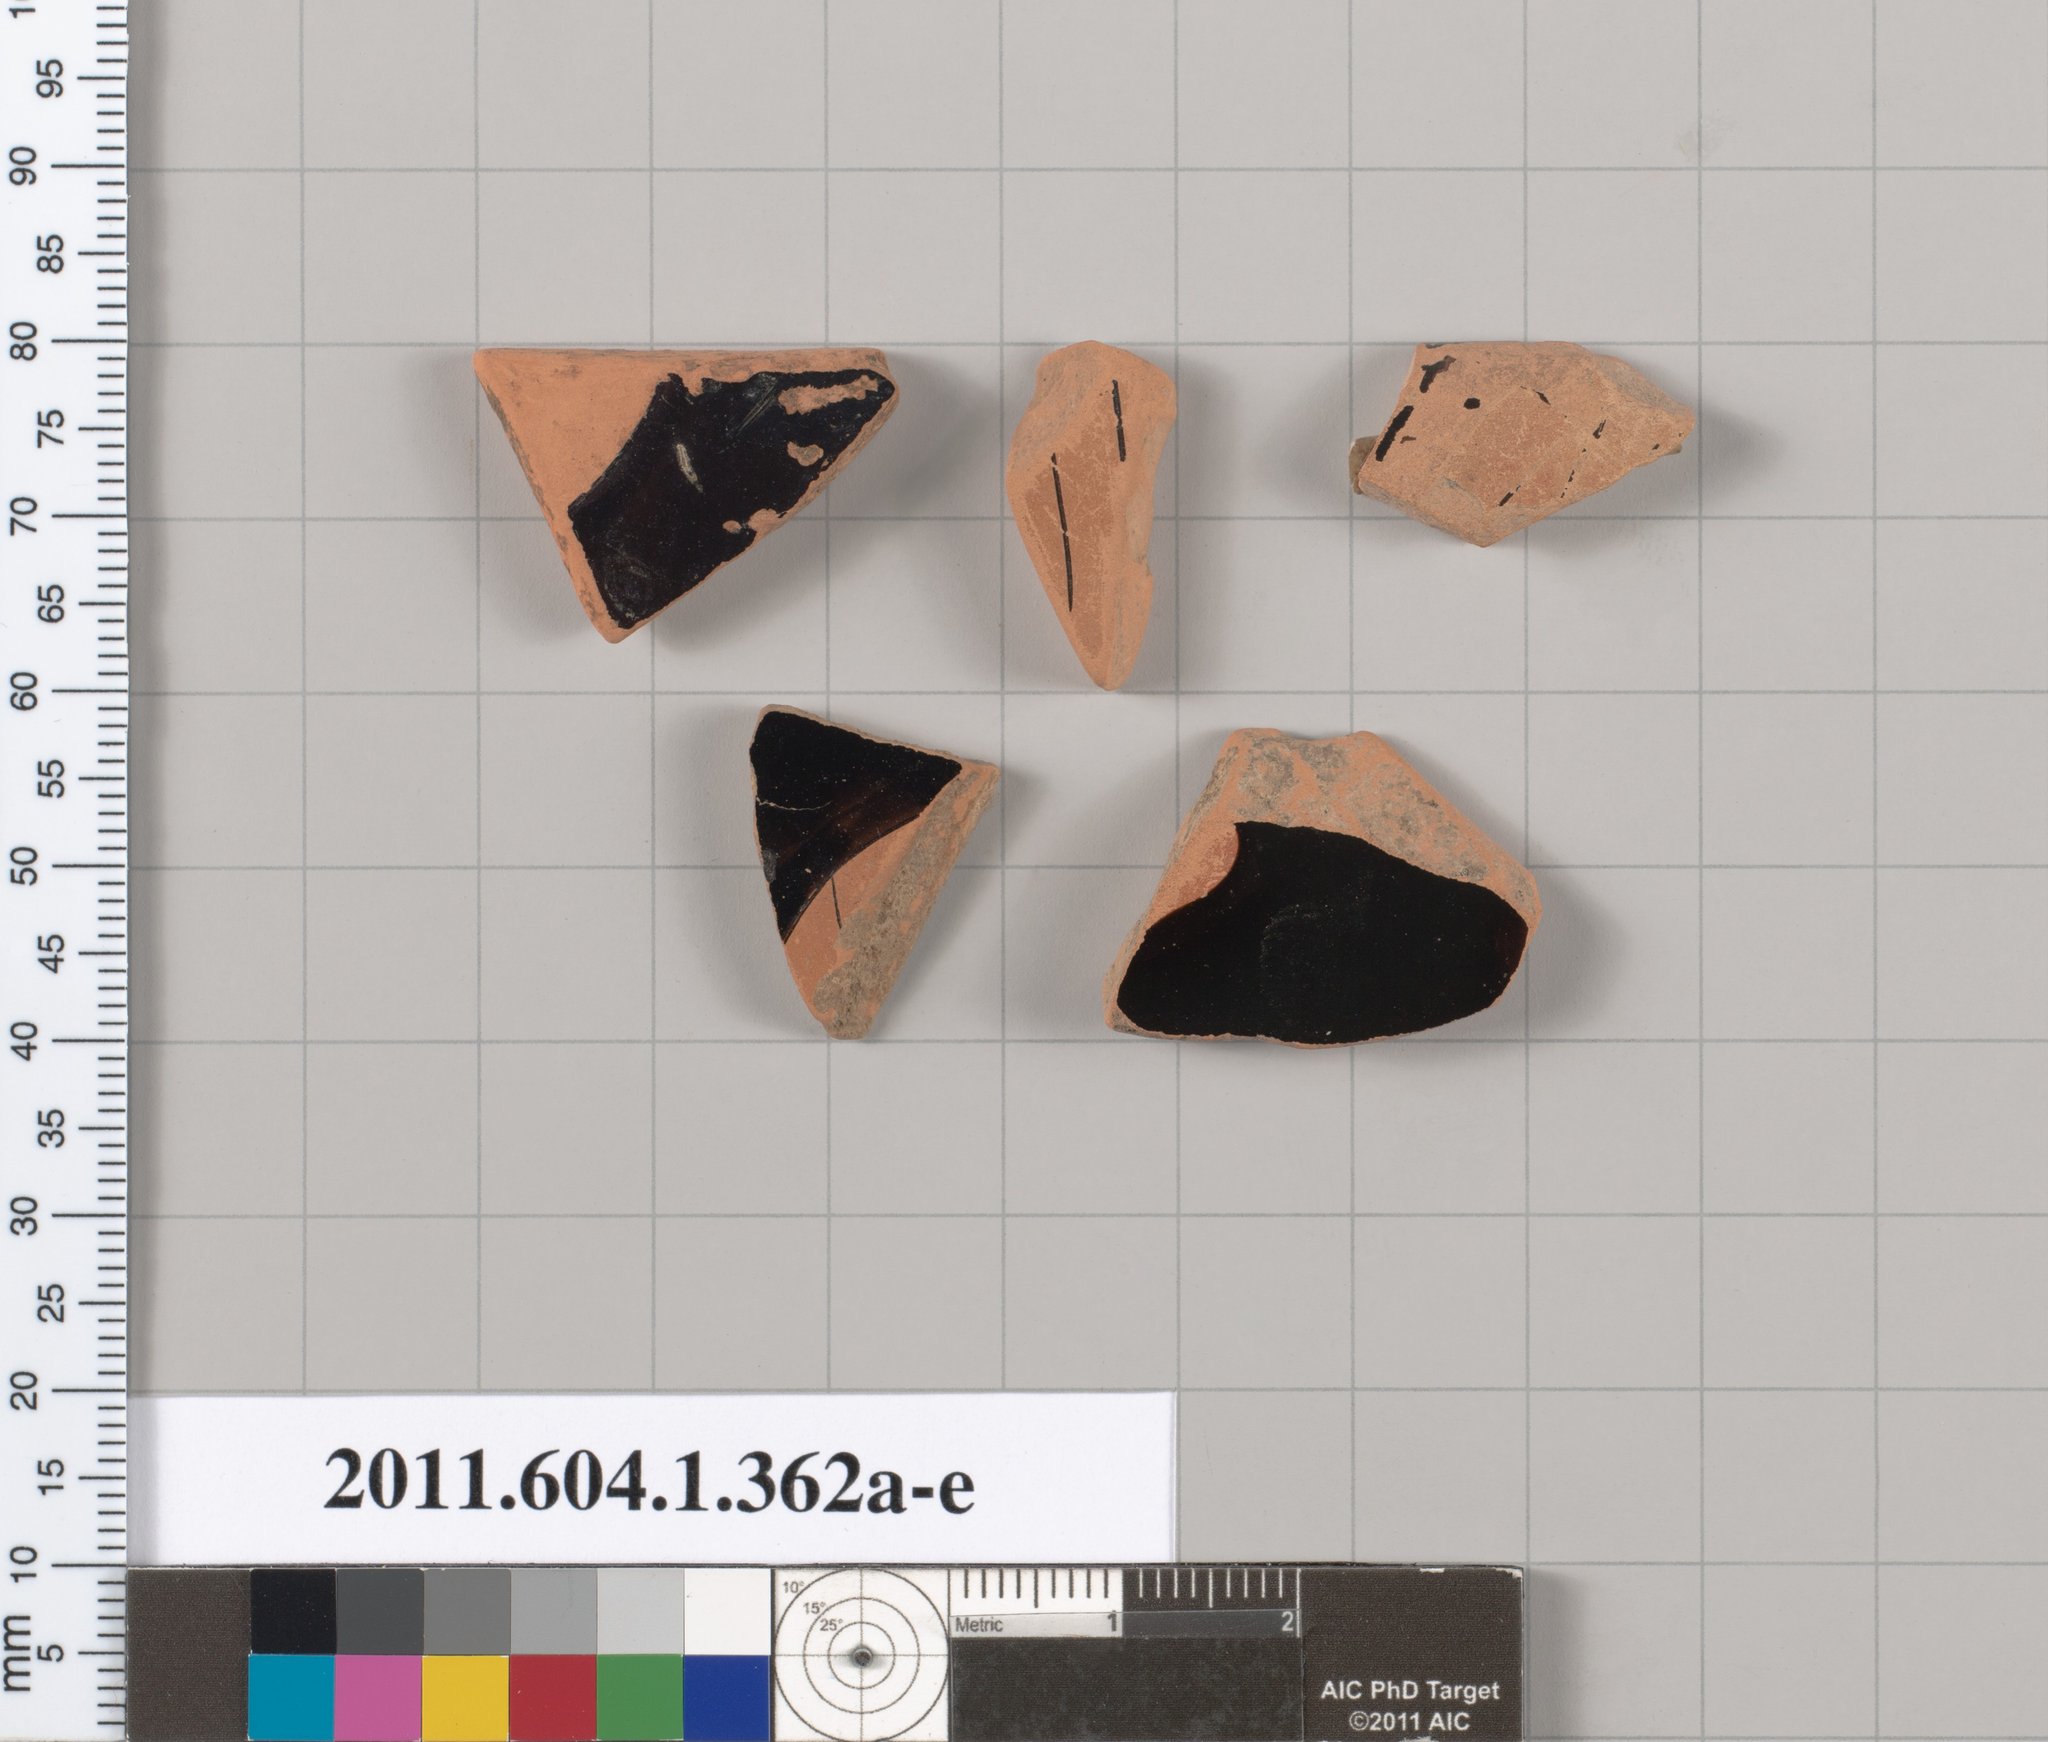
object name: kylix fragment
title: Terracotta fragments of kylikes(drinking cups)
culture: greek, attic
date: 475-451 BCE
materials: terracotta